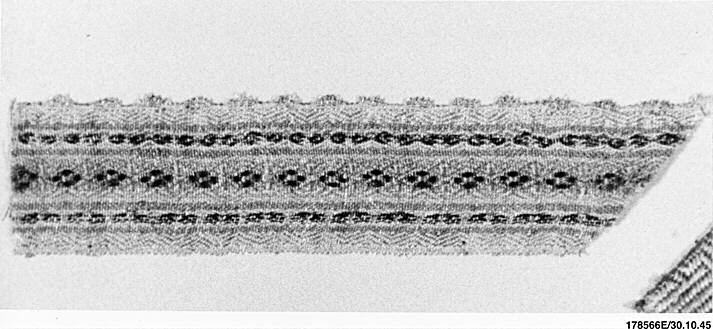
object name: ribbon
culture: chinese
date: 1801-1900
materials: metal thread, silk